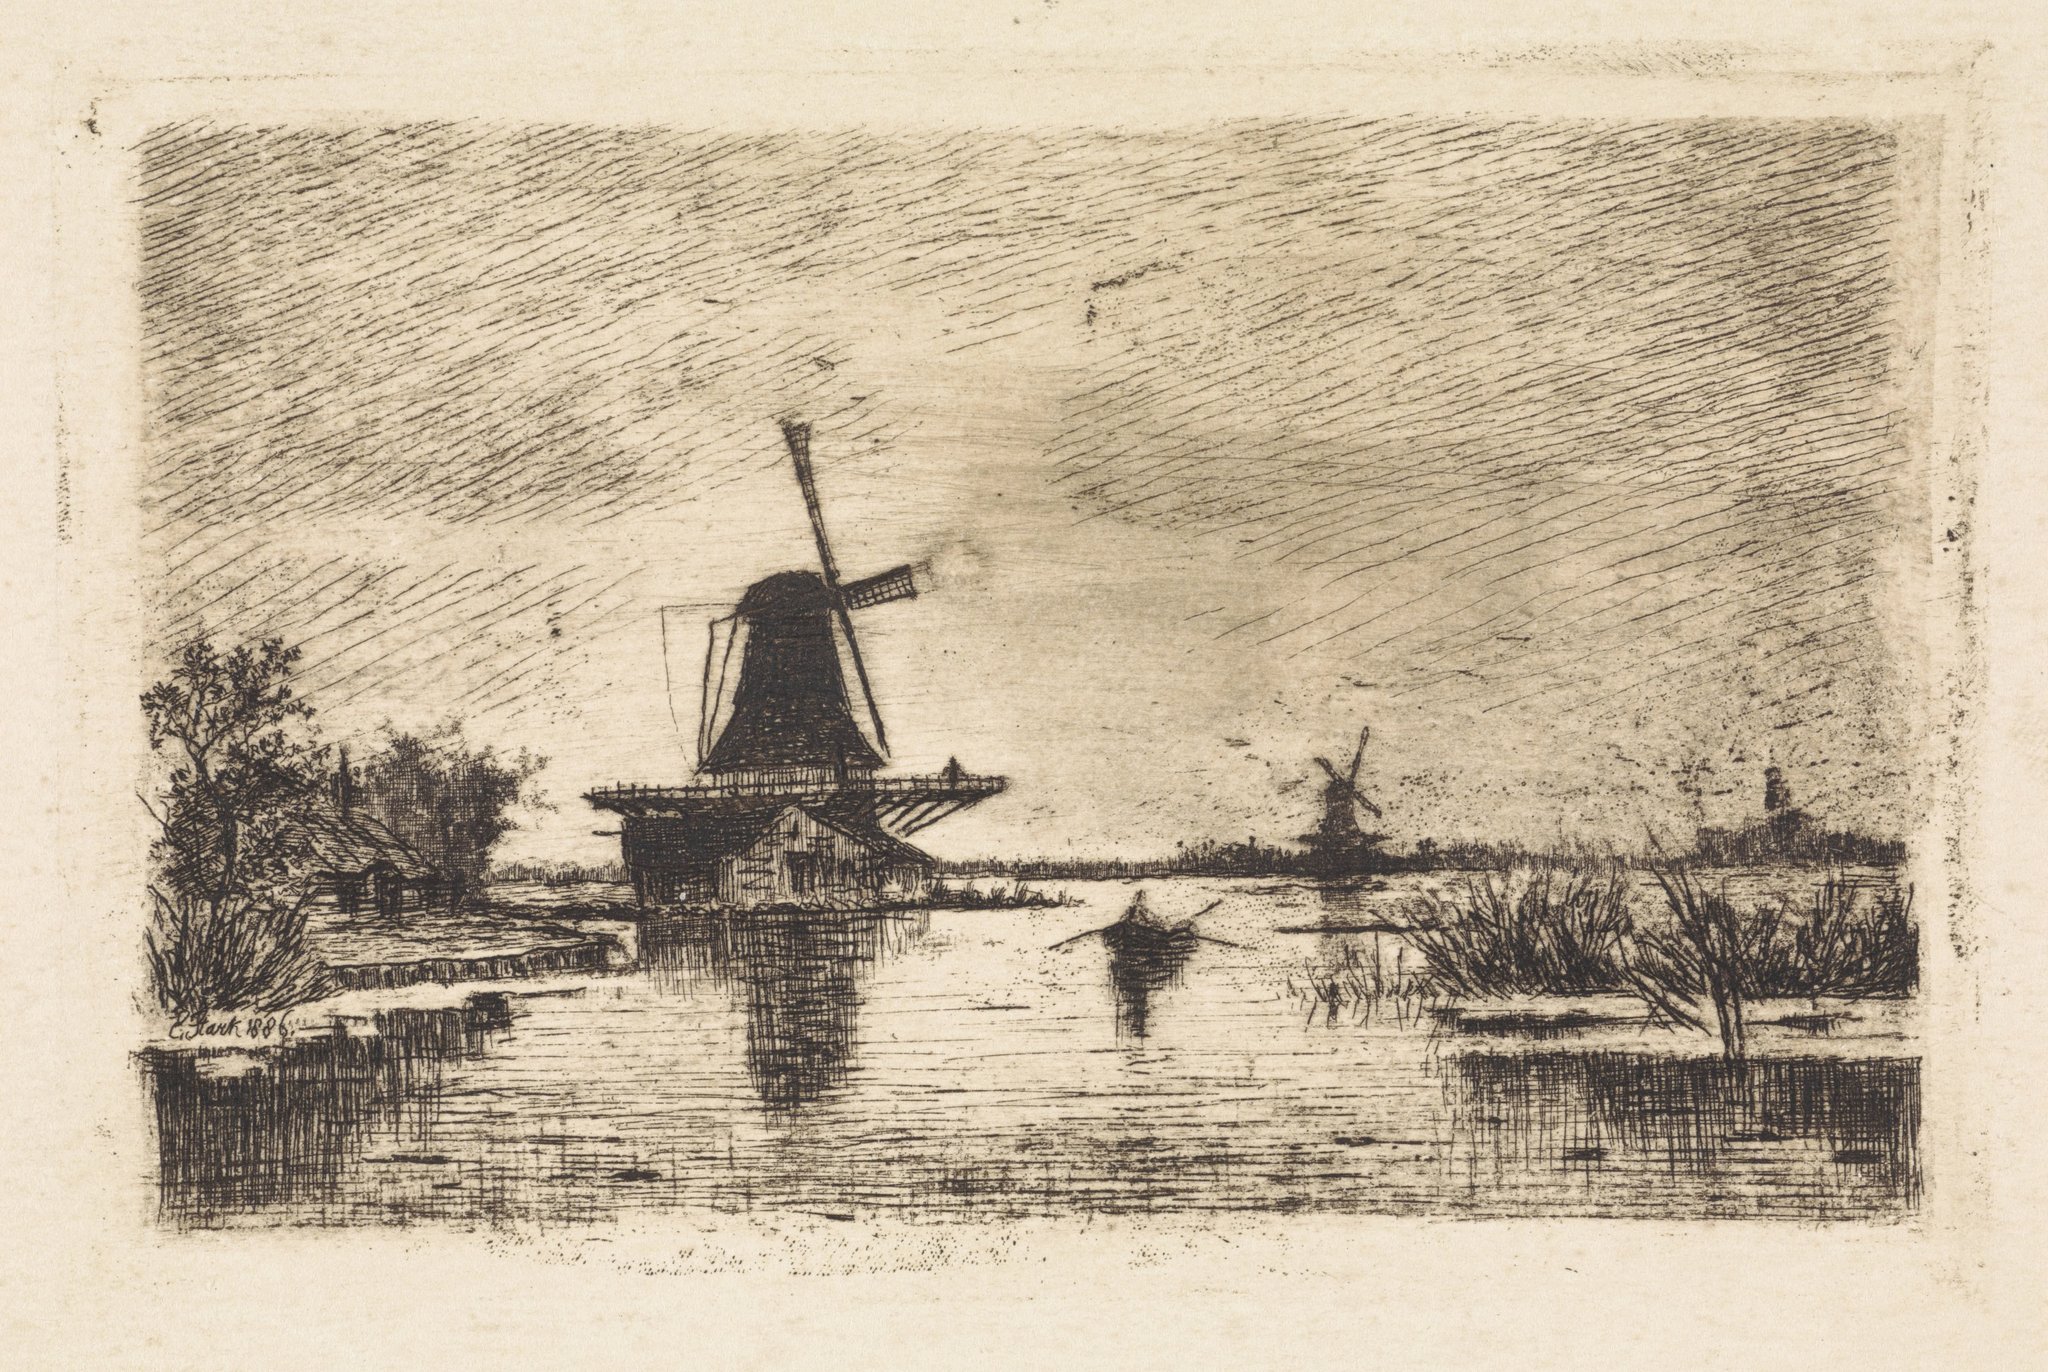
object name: print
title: Landschap met twee molens en een roeiboot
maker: elias stark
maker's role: draughtsman, print maker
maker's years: 1849-1933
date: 1886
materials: paper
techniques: etching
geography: nieuwer-amstel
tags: rowing-boat, canoe, etc., windmill in landscape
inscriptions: collector's mark: Lugt 2228